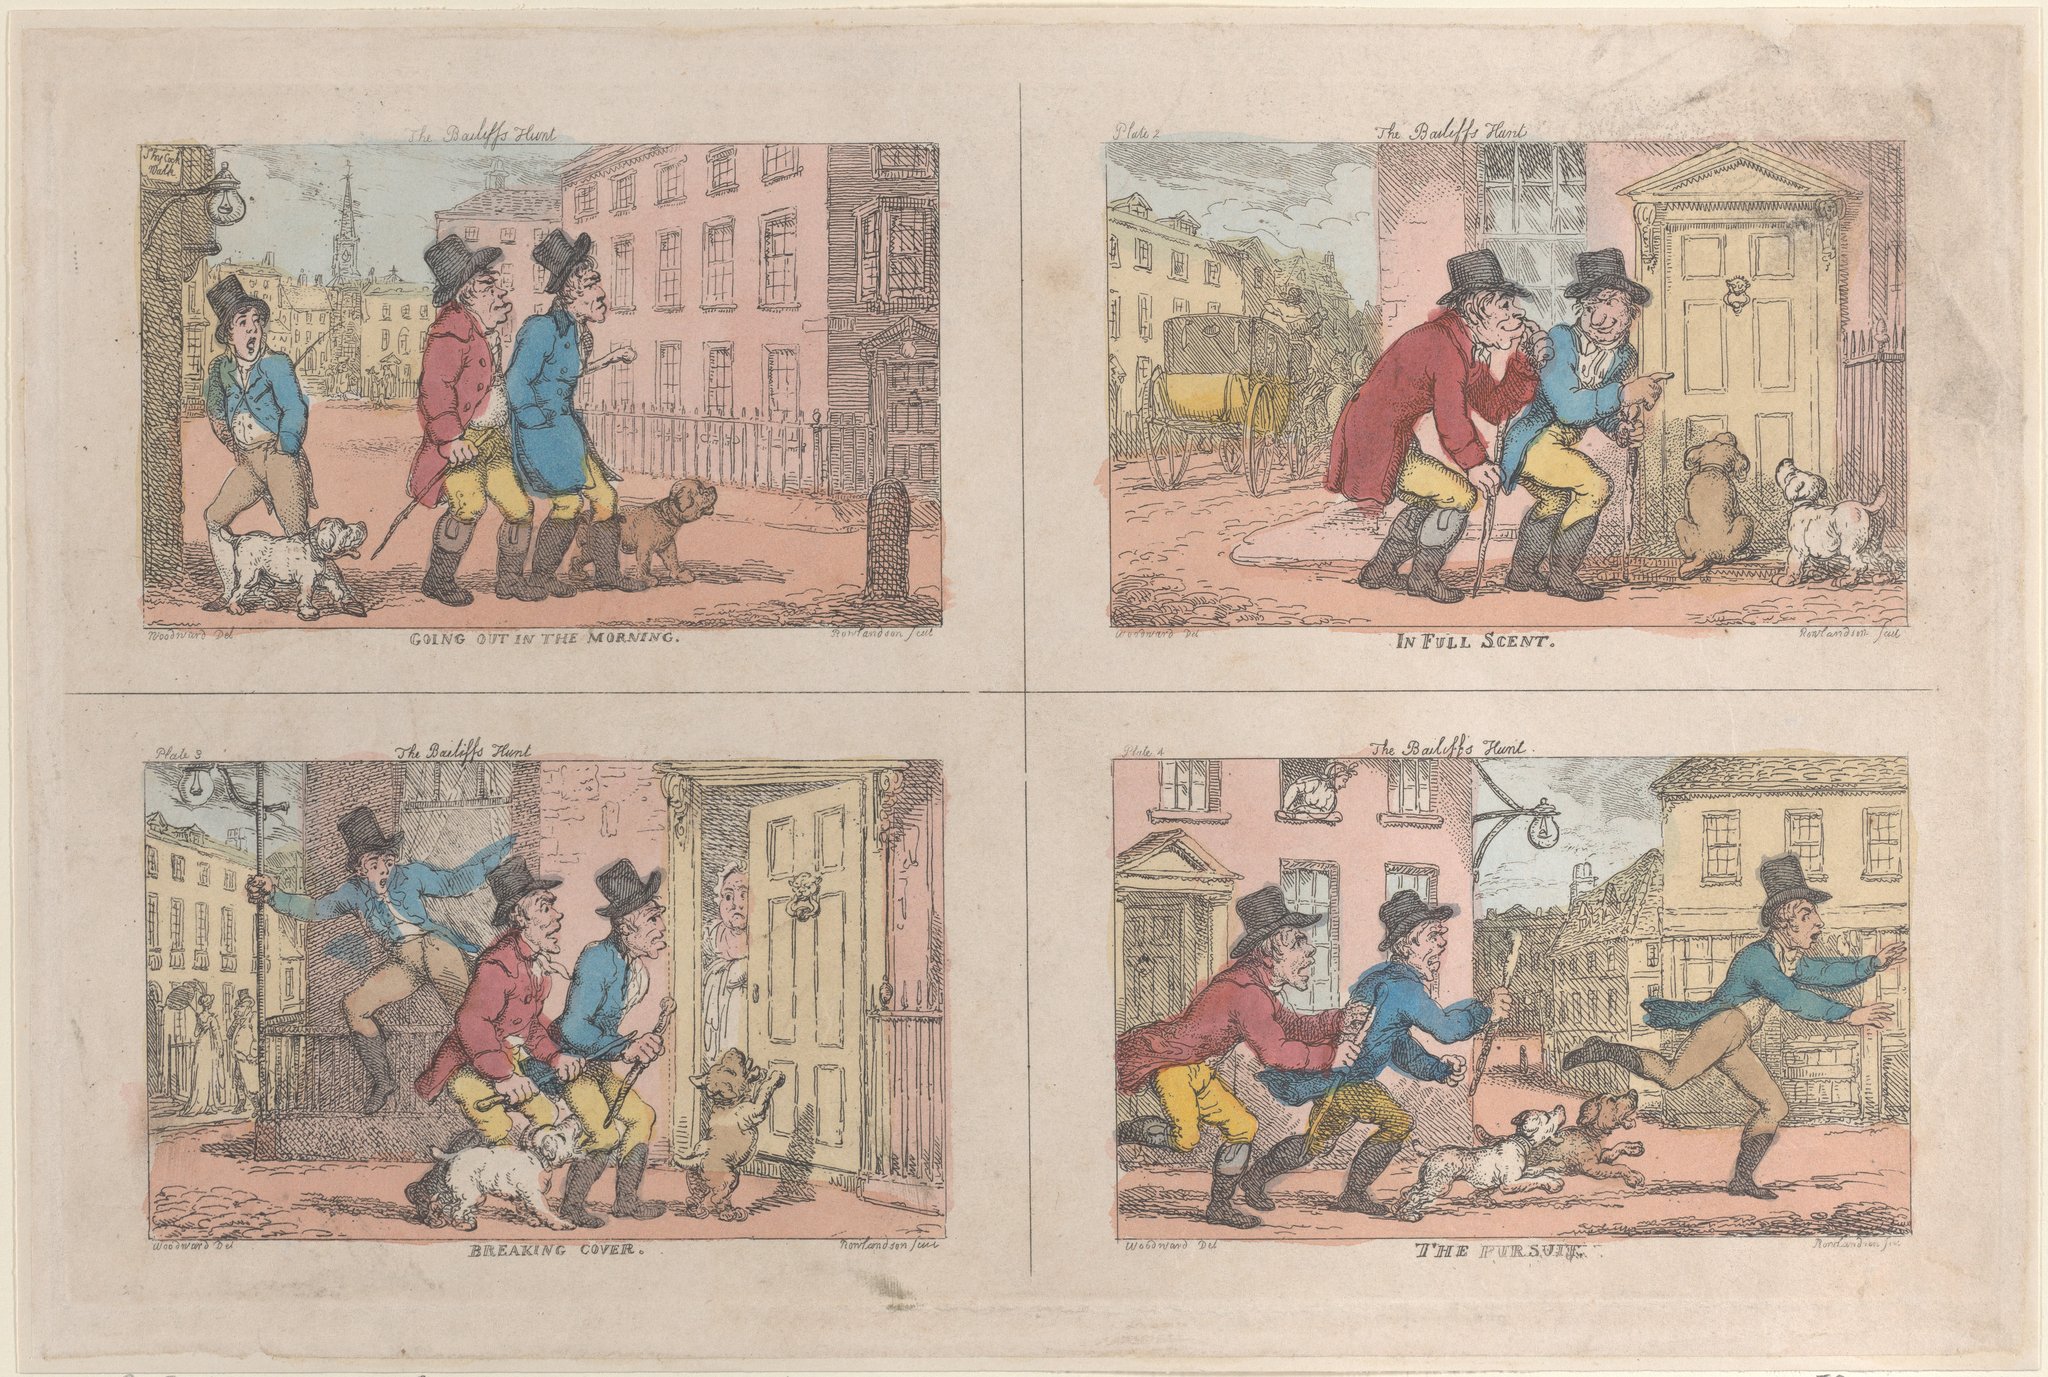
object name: print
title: The Bailiff's Hunt: Going Out in the Morning, In Full Scent, Breaking Cover, and The Pursuit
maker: thomas rowlandson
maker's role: artist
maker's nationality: british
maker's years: 1757-1827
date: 1809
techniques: etching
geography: london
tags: satire,men,dogs